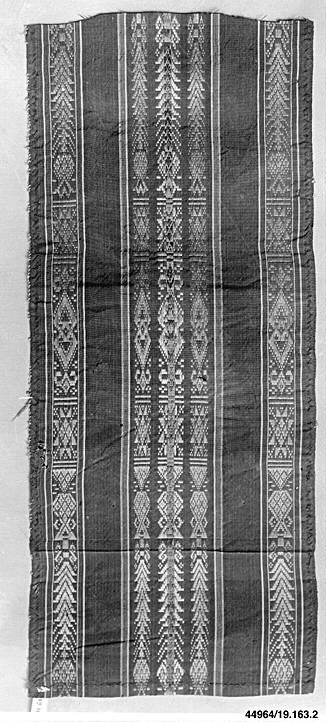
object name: textile fragment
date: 1701-1800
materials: silk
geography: morocco